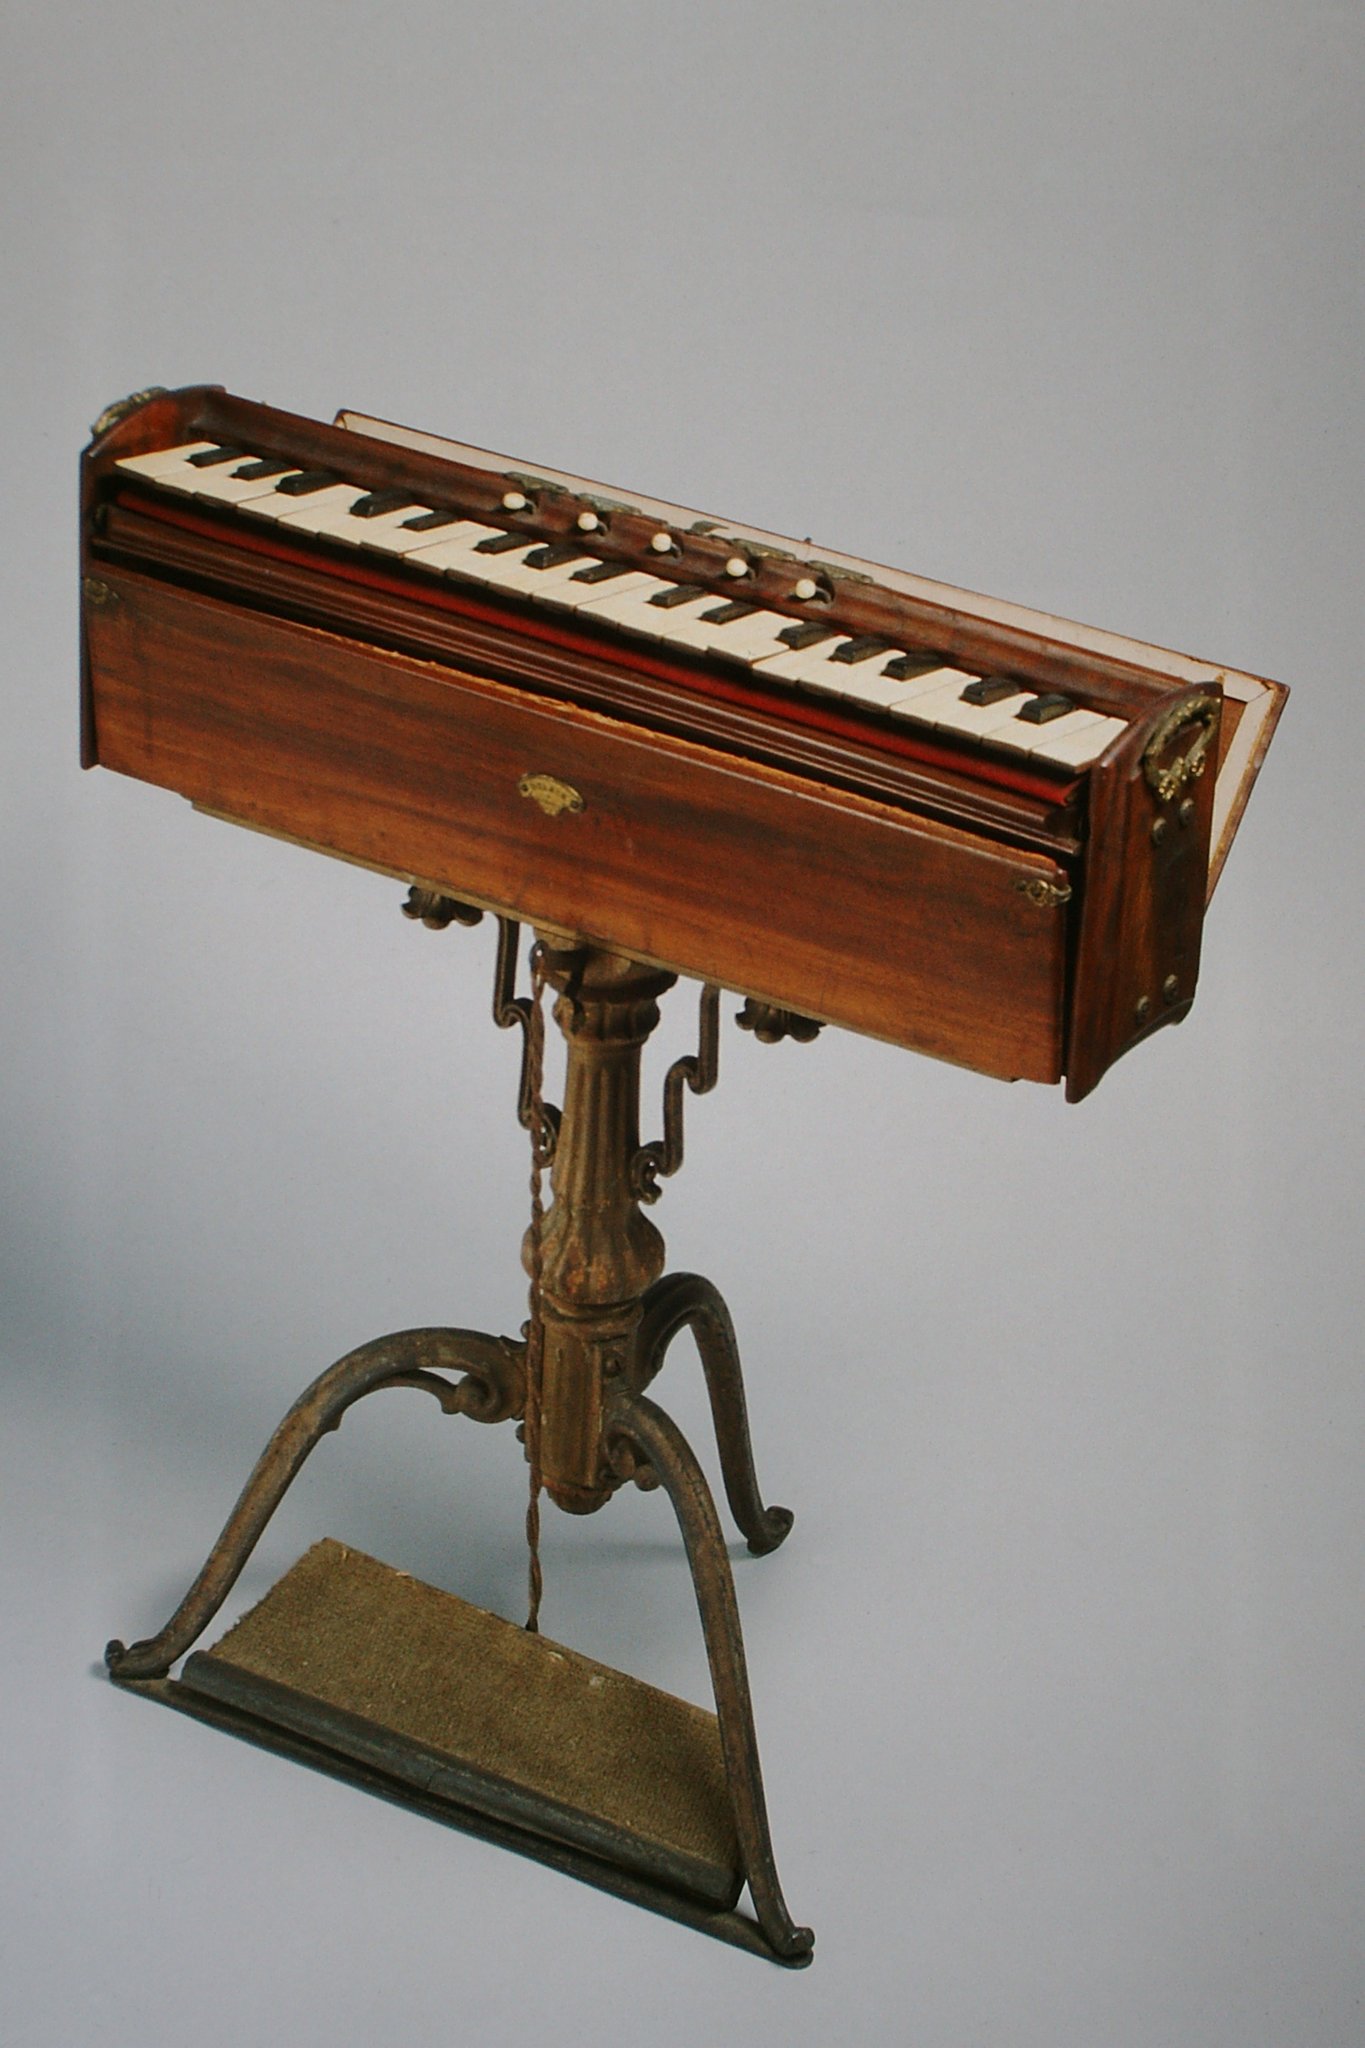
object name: reed organ physharmonika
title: Reed Organ (Physharmonika)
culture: french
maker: alexander-françois debain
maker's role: maker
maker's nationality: french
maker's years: 1809-1877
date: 1801-1833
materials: metal, wood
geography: france